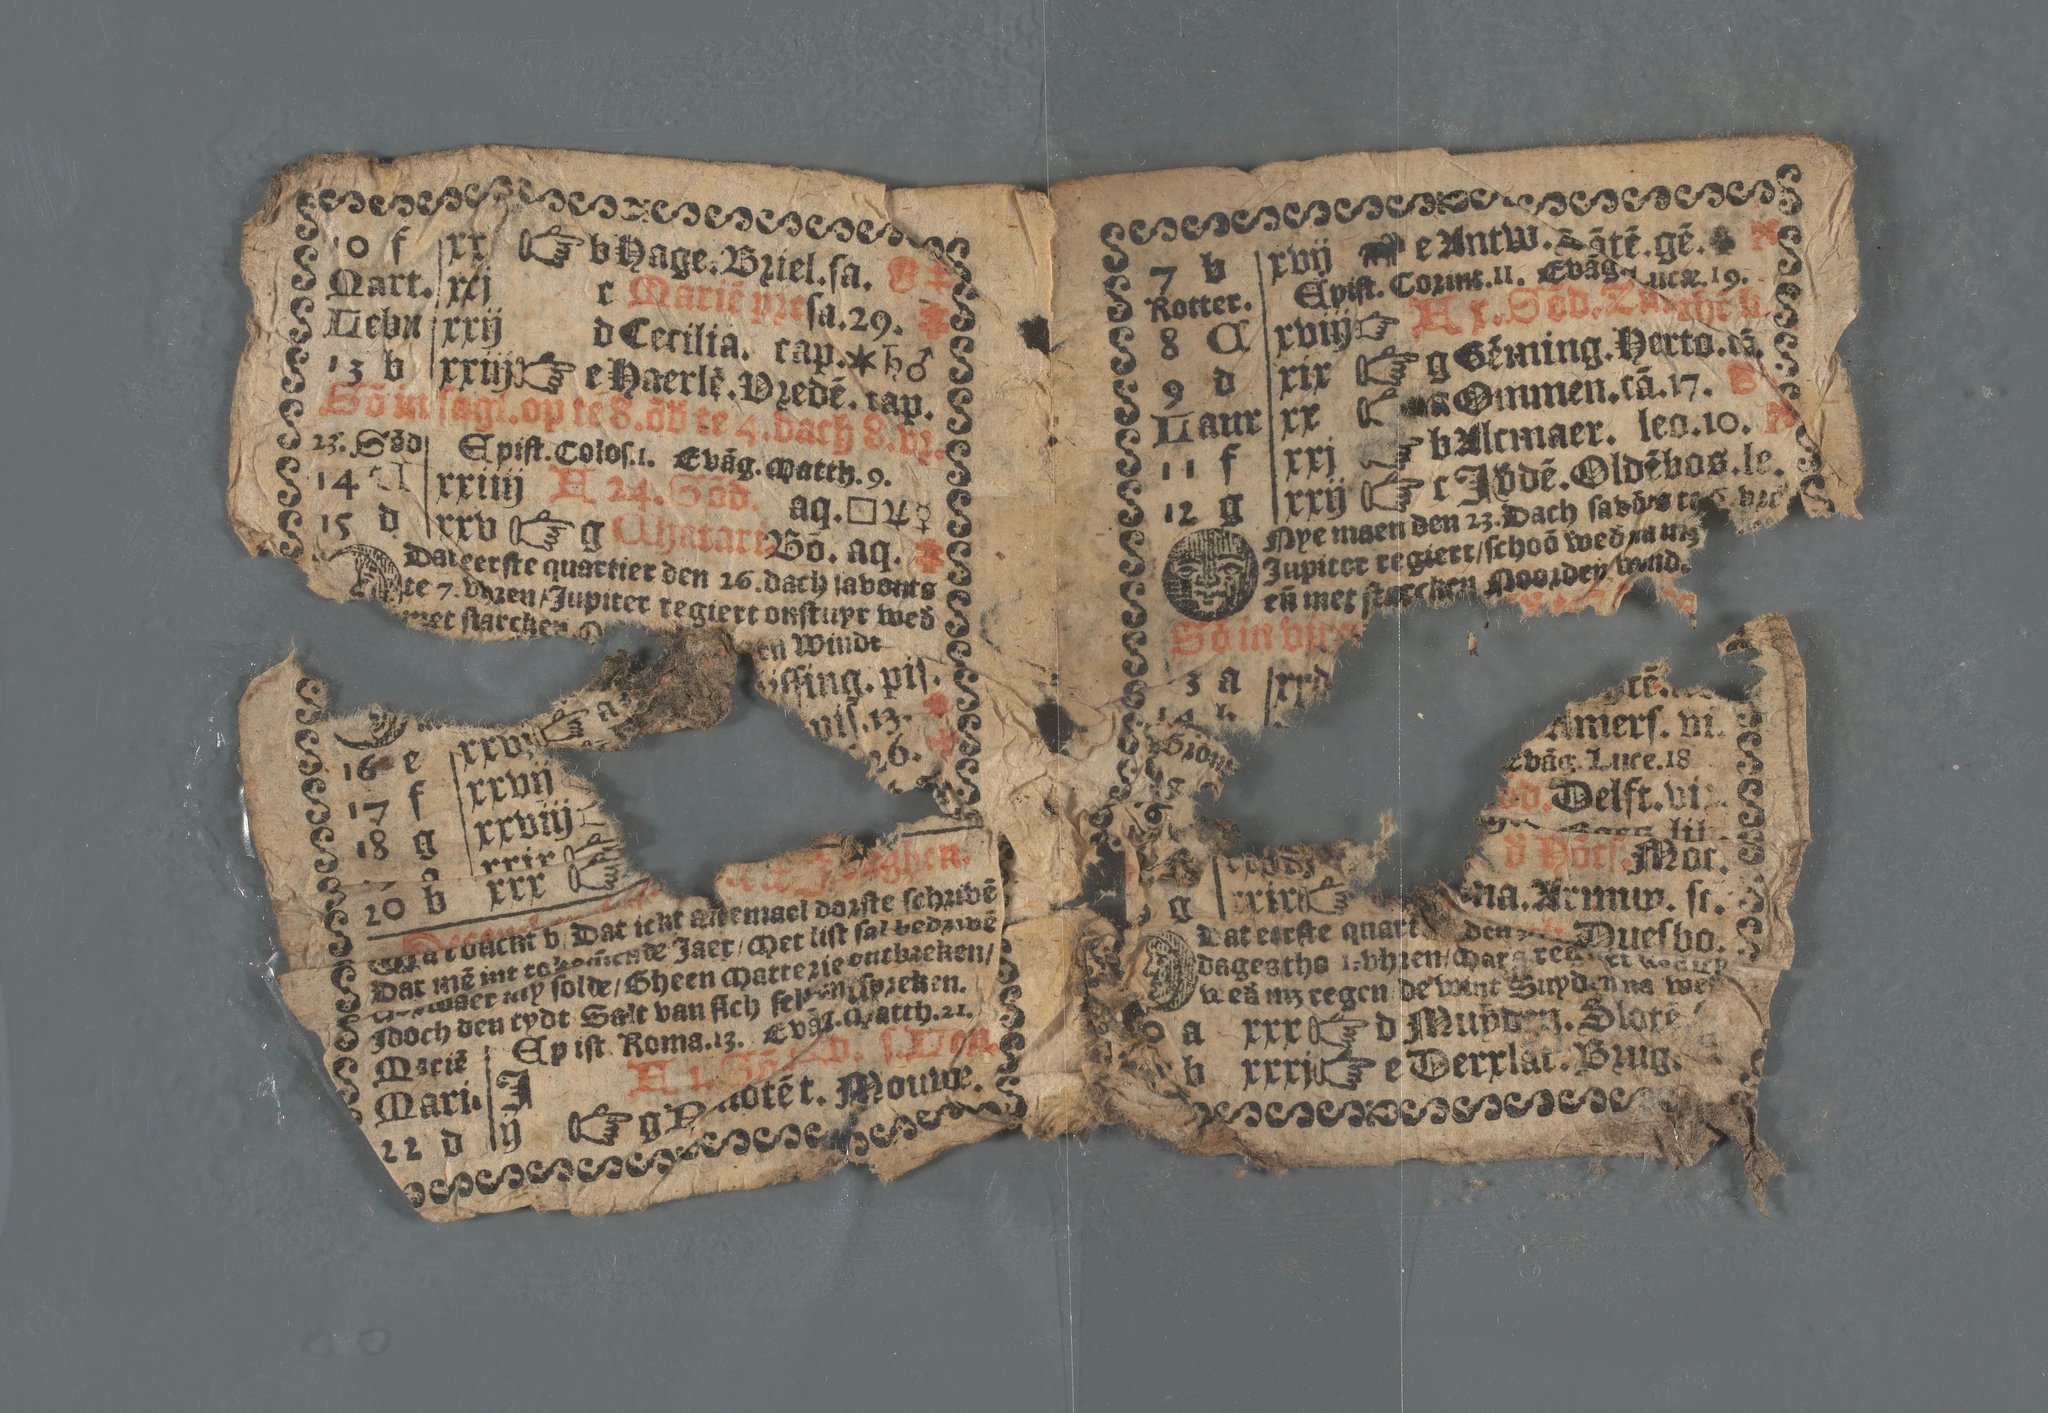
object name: page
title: Bladzijde uit een Deventer almanak voor het schrikkeljaar 1596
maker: Anonymous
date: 1596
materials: paper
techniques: printing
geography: enkhuizen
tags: willem barendsz., jacob van heemskerck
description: Bladzijde uit een Deventer almanak voor het schrikkeljaar 1596. Eerste middenkatern, opengeslagen.